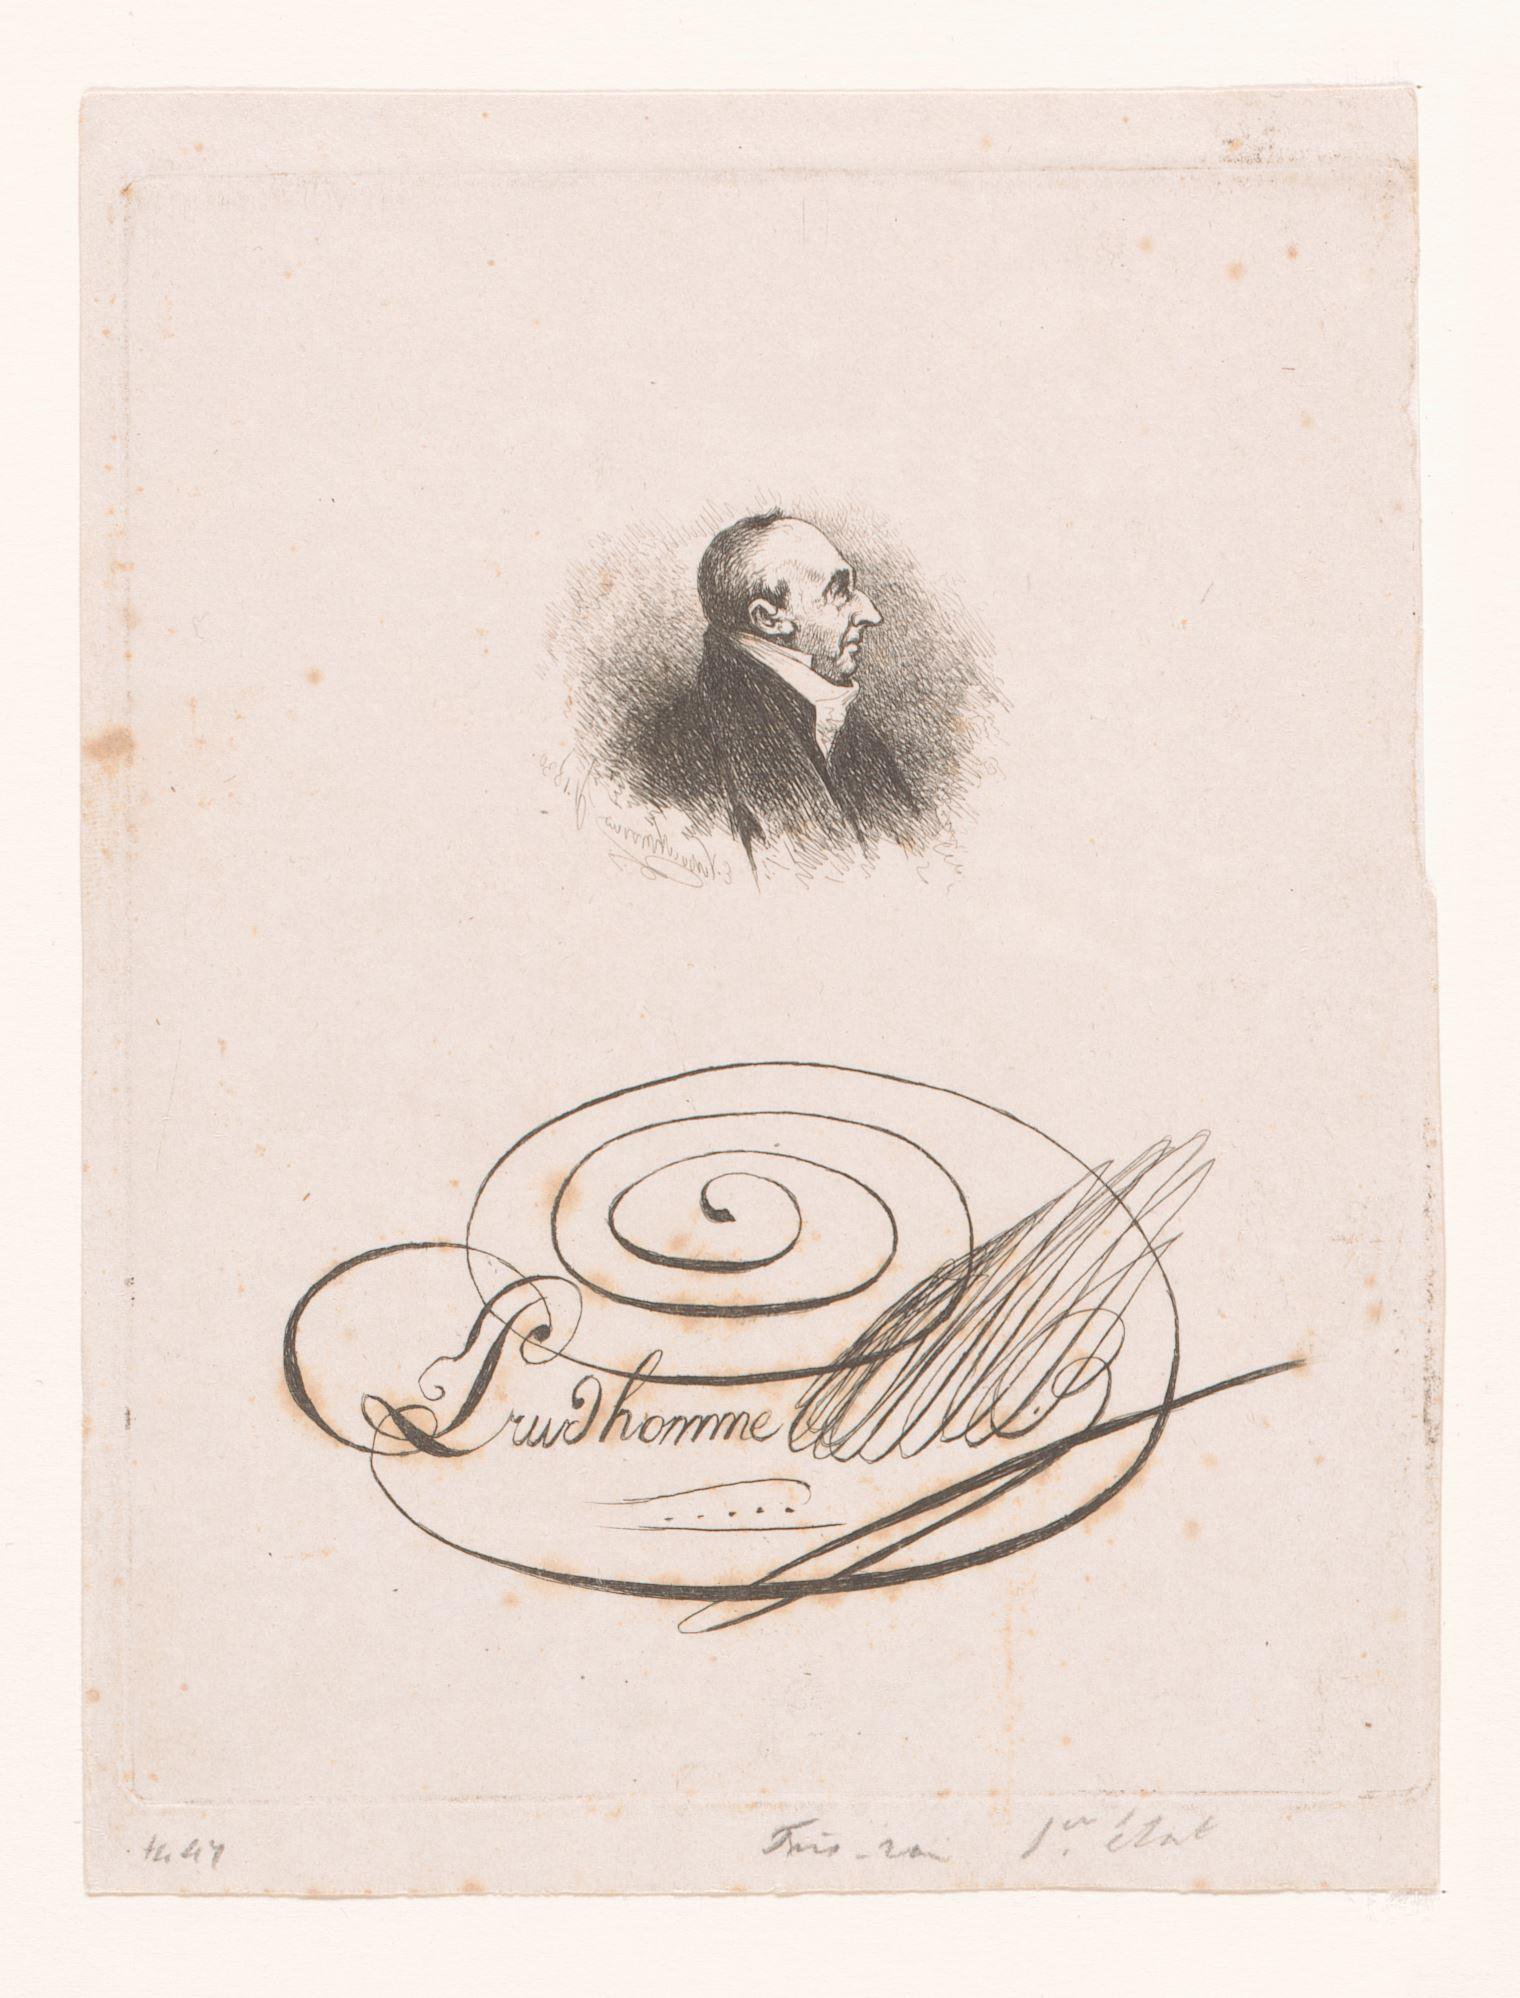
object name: book illustration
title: Portret van Joseph Prudhomme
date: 1830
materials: ink, paper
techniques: etching, pen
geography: paris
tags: caricatures (human types), bourgeoisie, middle class, citizens, burghers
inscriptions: date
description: Portret van het karikaturale personage Joseph Prudhomme. Onder zijn beeltenis een fac simile van zijn zogenaamde handtekening.